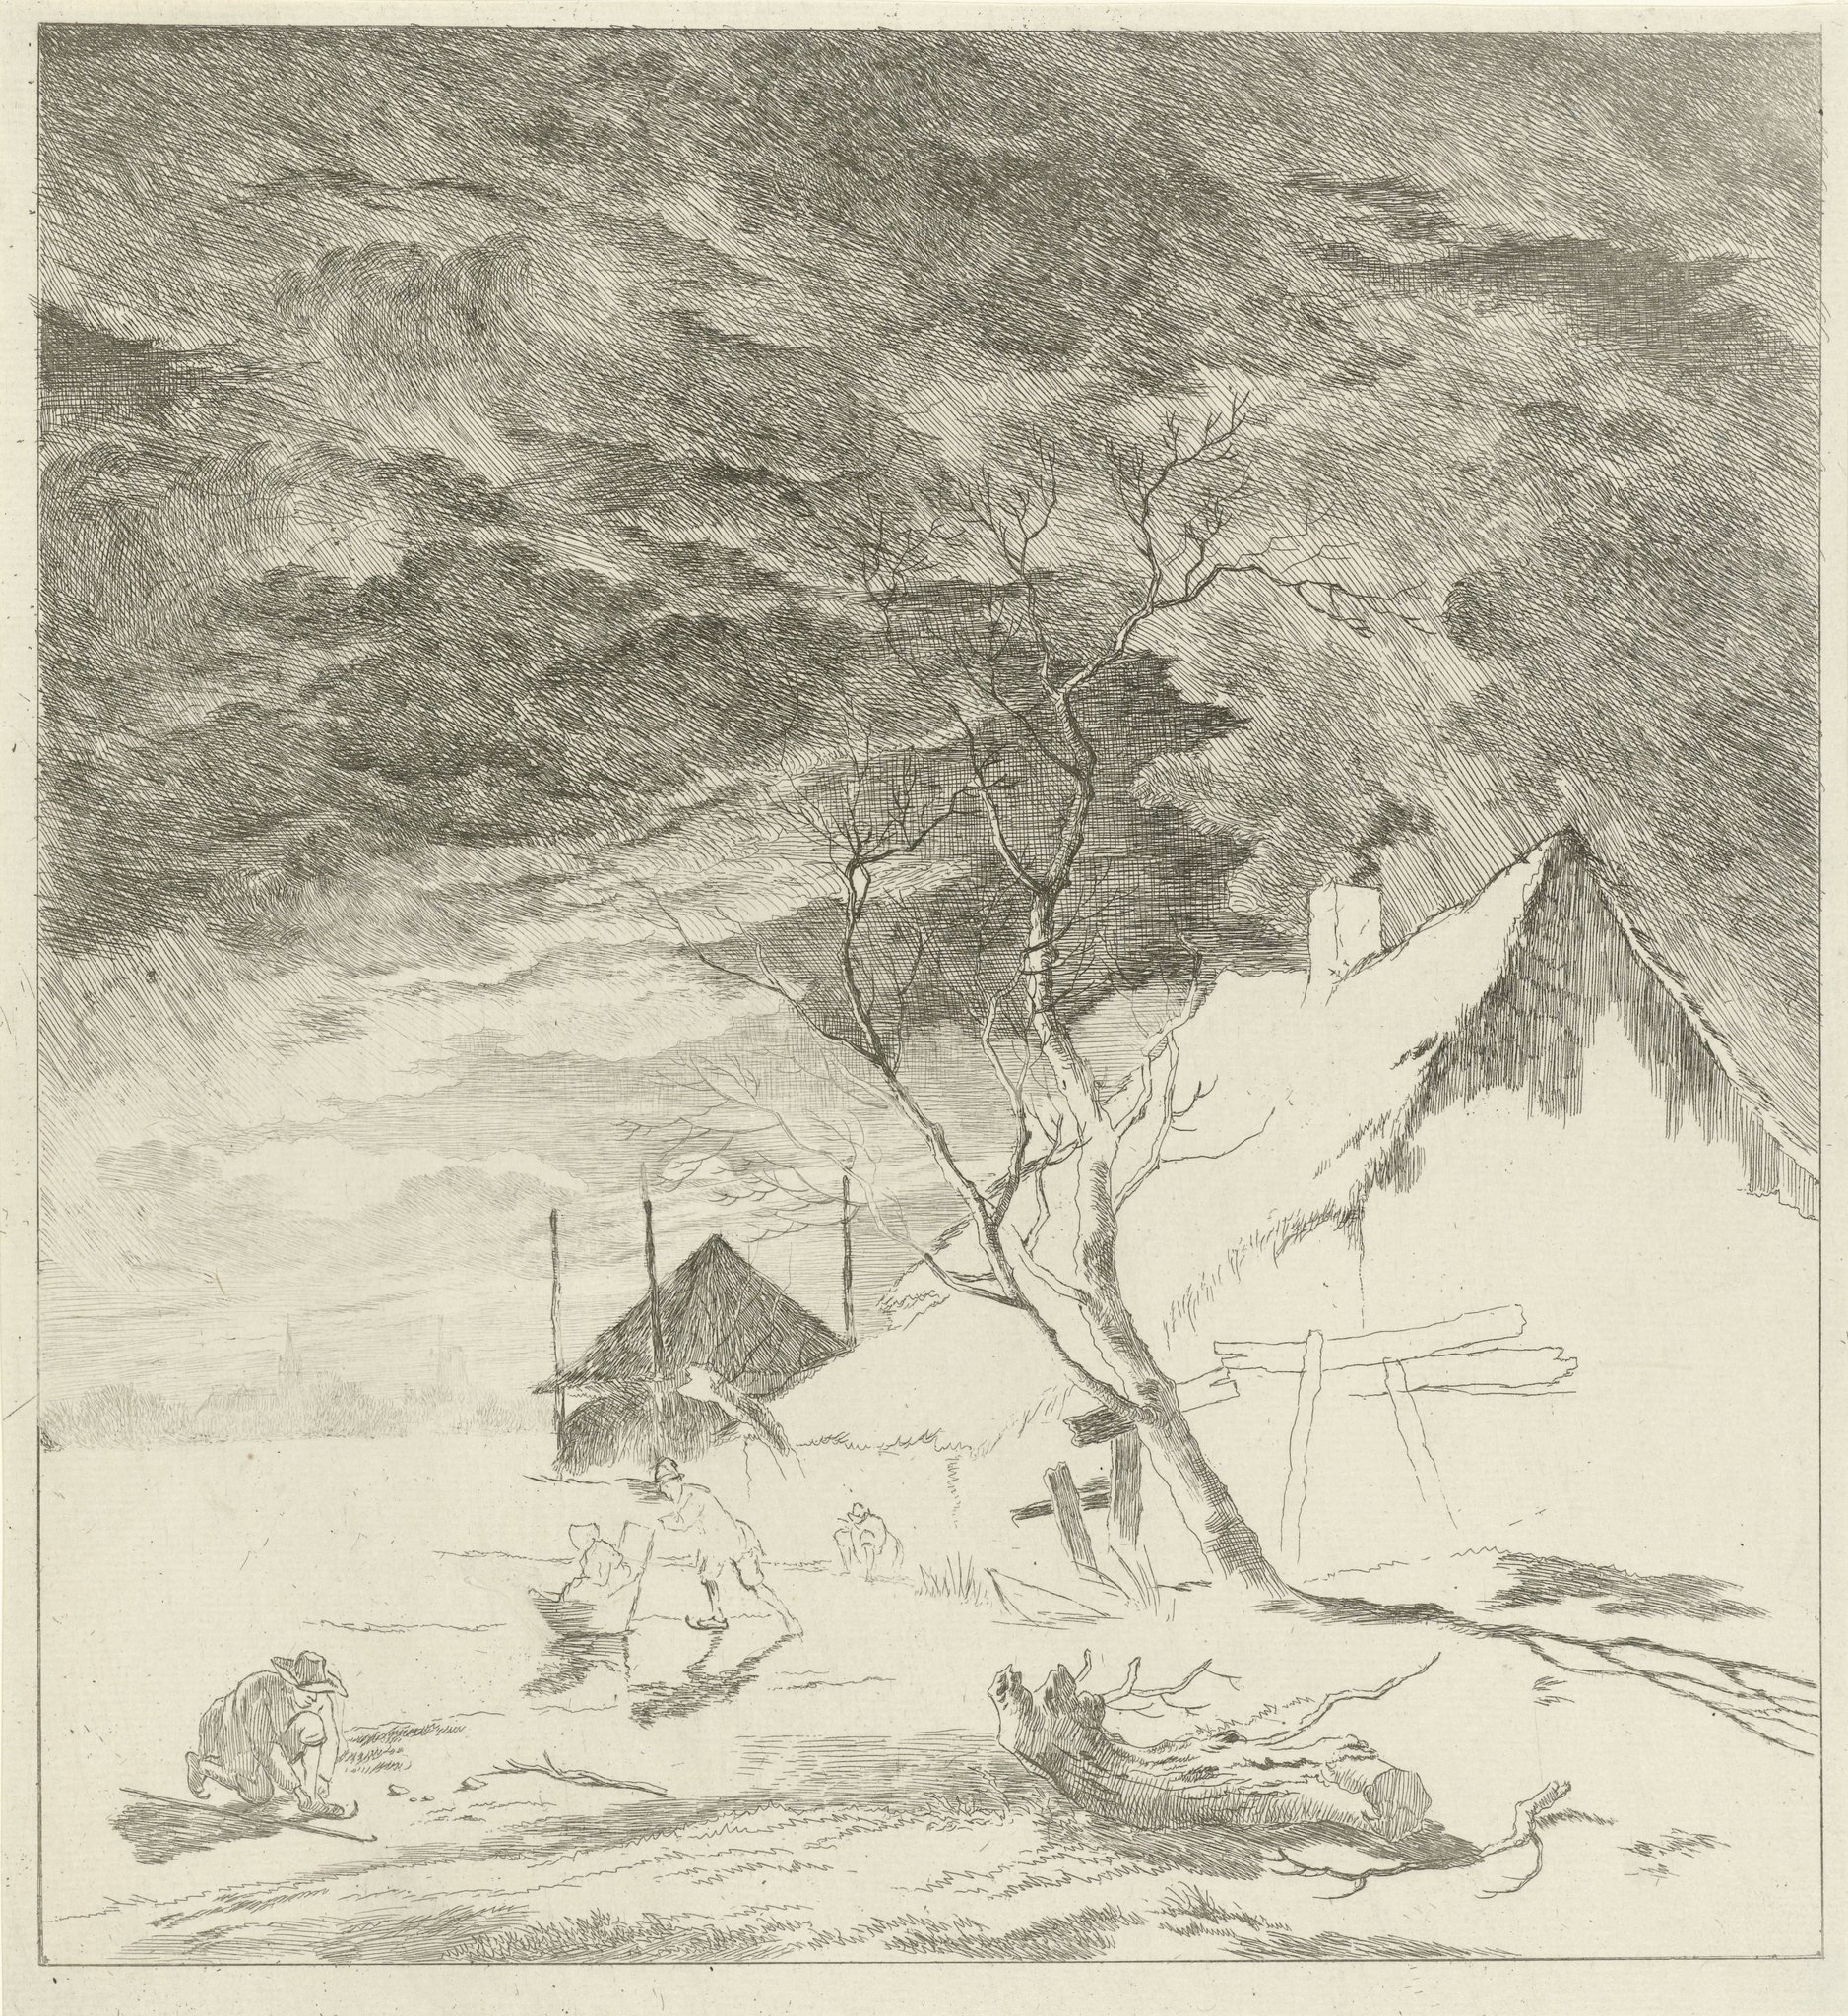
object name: print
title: Nachtlandschap met boerderij en schaatsers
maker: johannes janson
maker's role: draughtsman, painter, print maker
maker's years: 1729-1784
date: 1761-1784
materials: paper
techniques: etching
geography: leiden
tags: winter ~ human activities (the four seasons of the year), night ~ landscape (sometimes titled 'nox')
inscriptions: collector's mark: Lugt 2228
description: Nachtlandschap met maneschijn en rechts een boerderij en hooischuur. Links een bevroren meer met schaatsers. Alléén de lucht bewerkt.